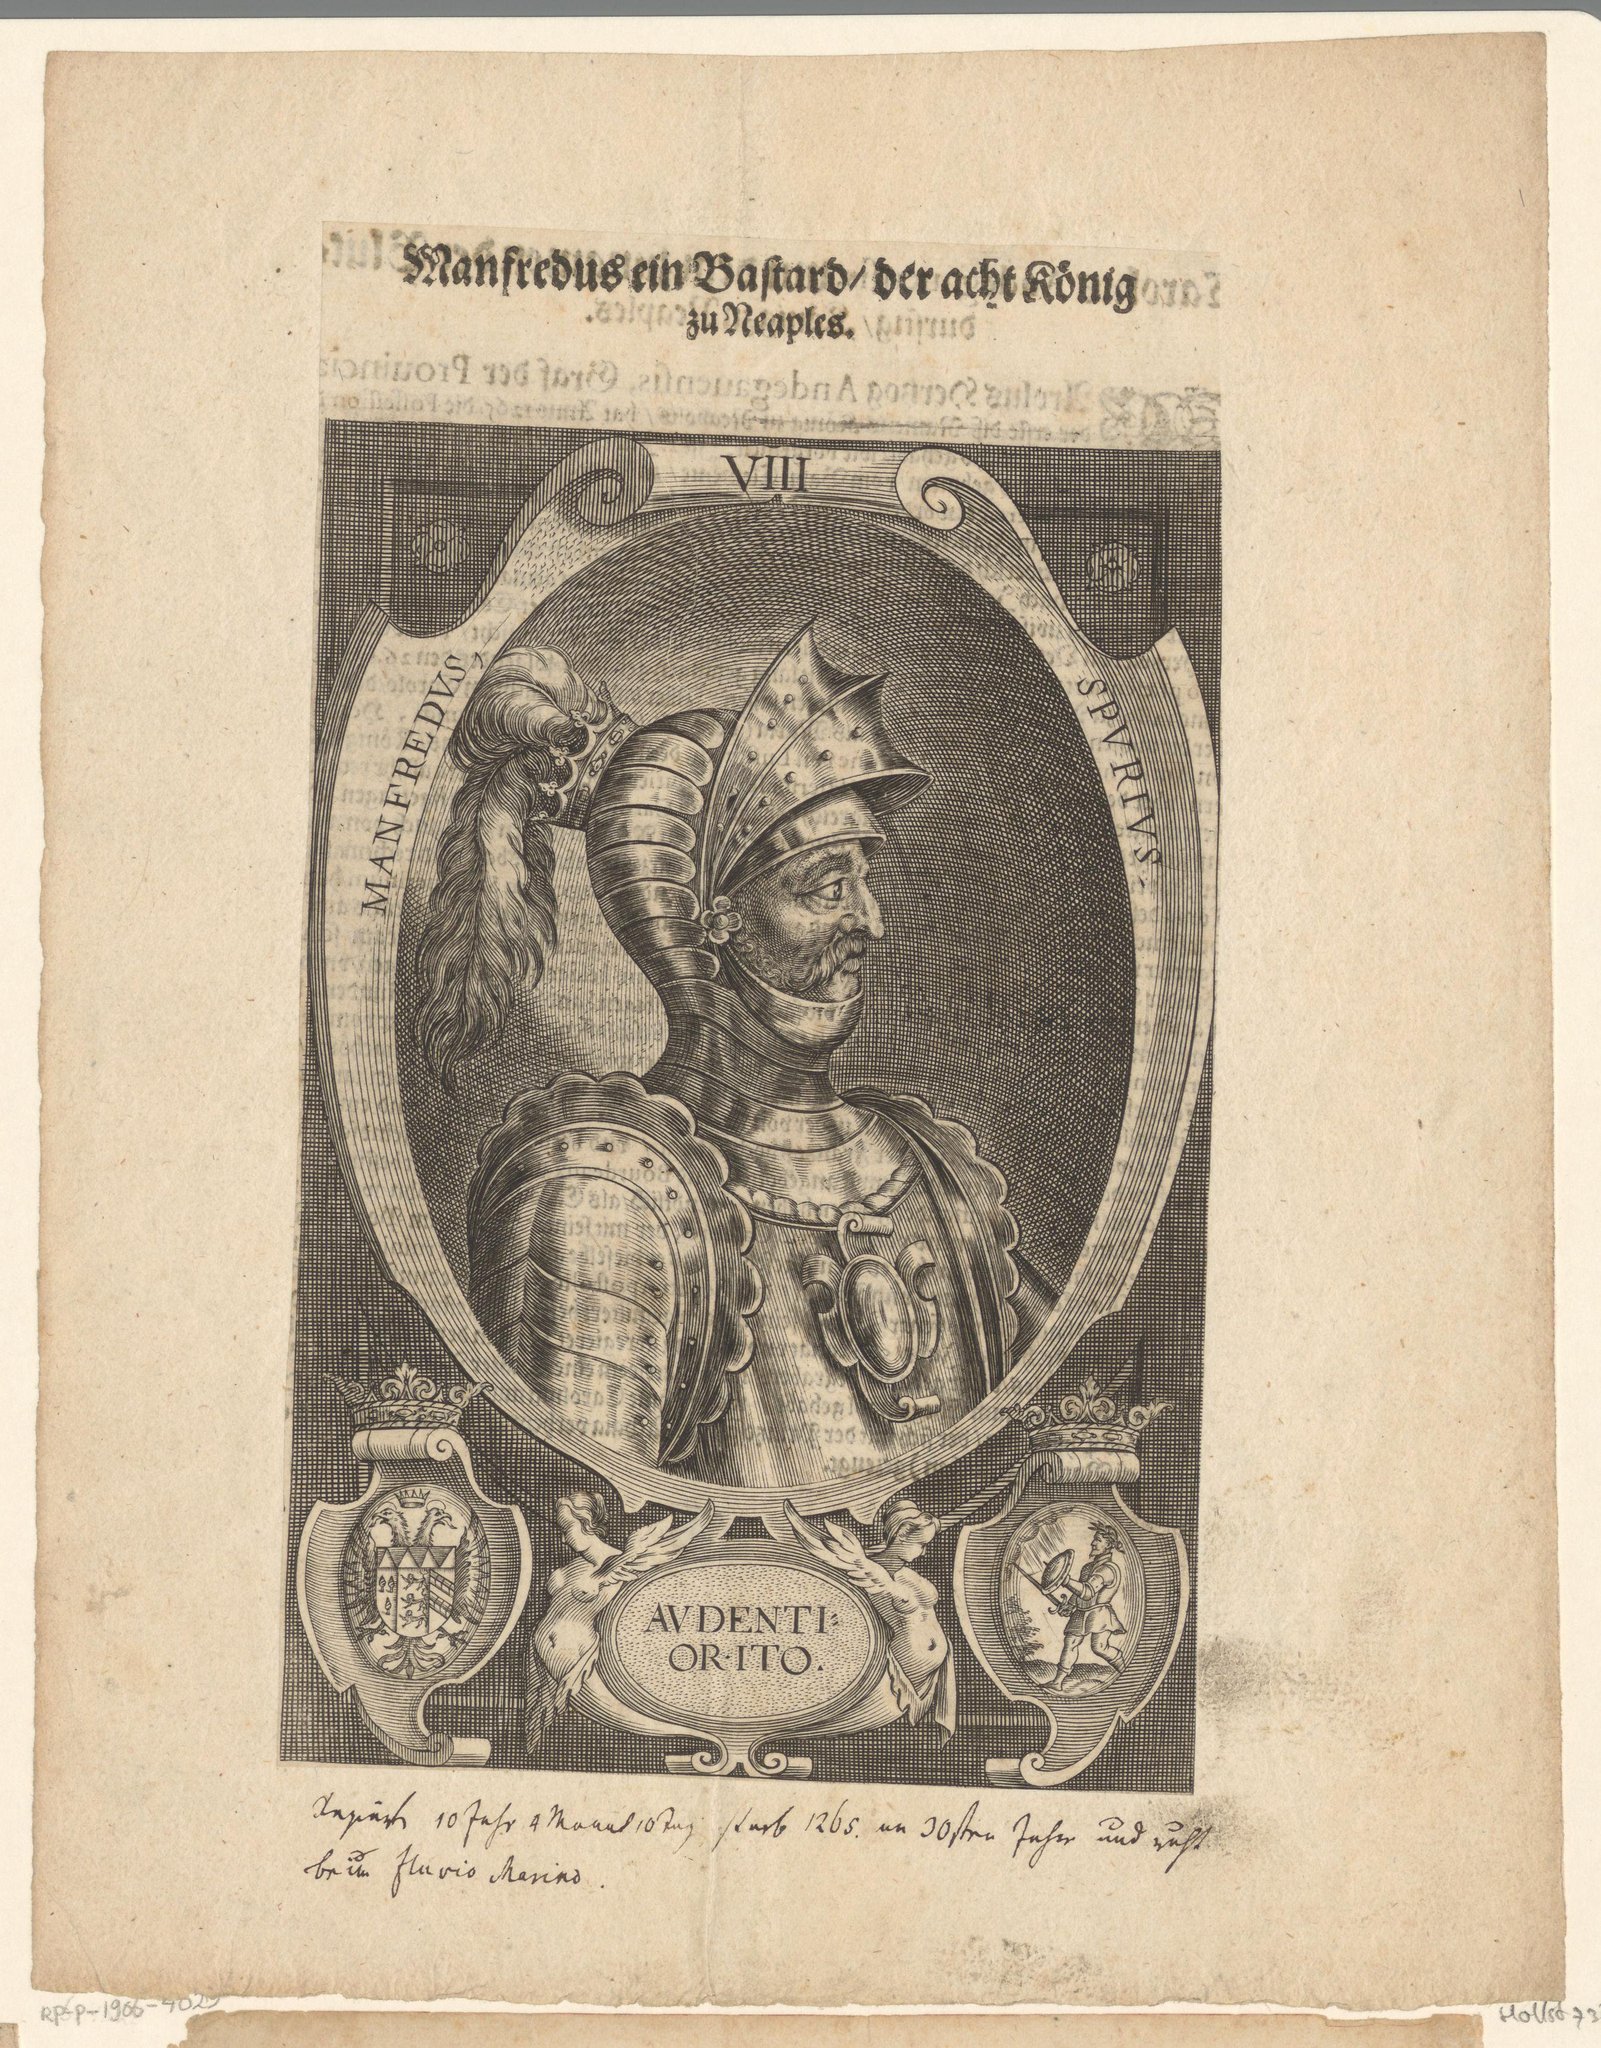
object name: book illustration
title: Portret van Manfred van Sicilië, koning van Napels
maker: lucas kilian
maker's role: draughtsman, print maker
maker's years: 1579-1637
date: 1589-1624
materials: paper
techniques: engraving, etching, letterpress printing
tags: venosa, historical persons, king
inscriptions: collector's mark: Lugt 2228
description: Deze prent is gebruikt in: Mazzella, Scipione, Kilian, Lucas en Custos, Dominicus. Der Neapolitanische Koenige Leben und Bildnisse (...). Augsburg: Lucas Kilian, 1624.